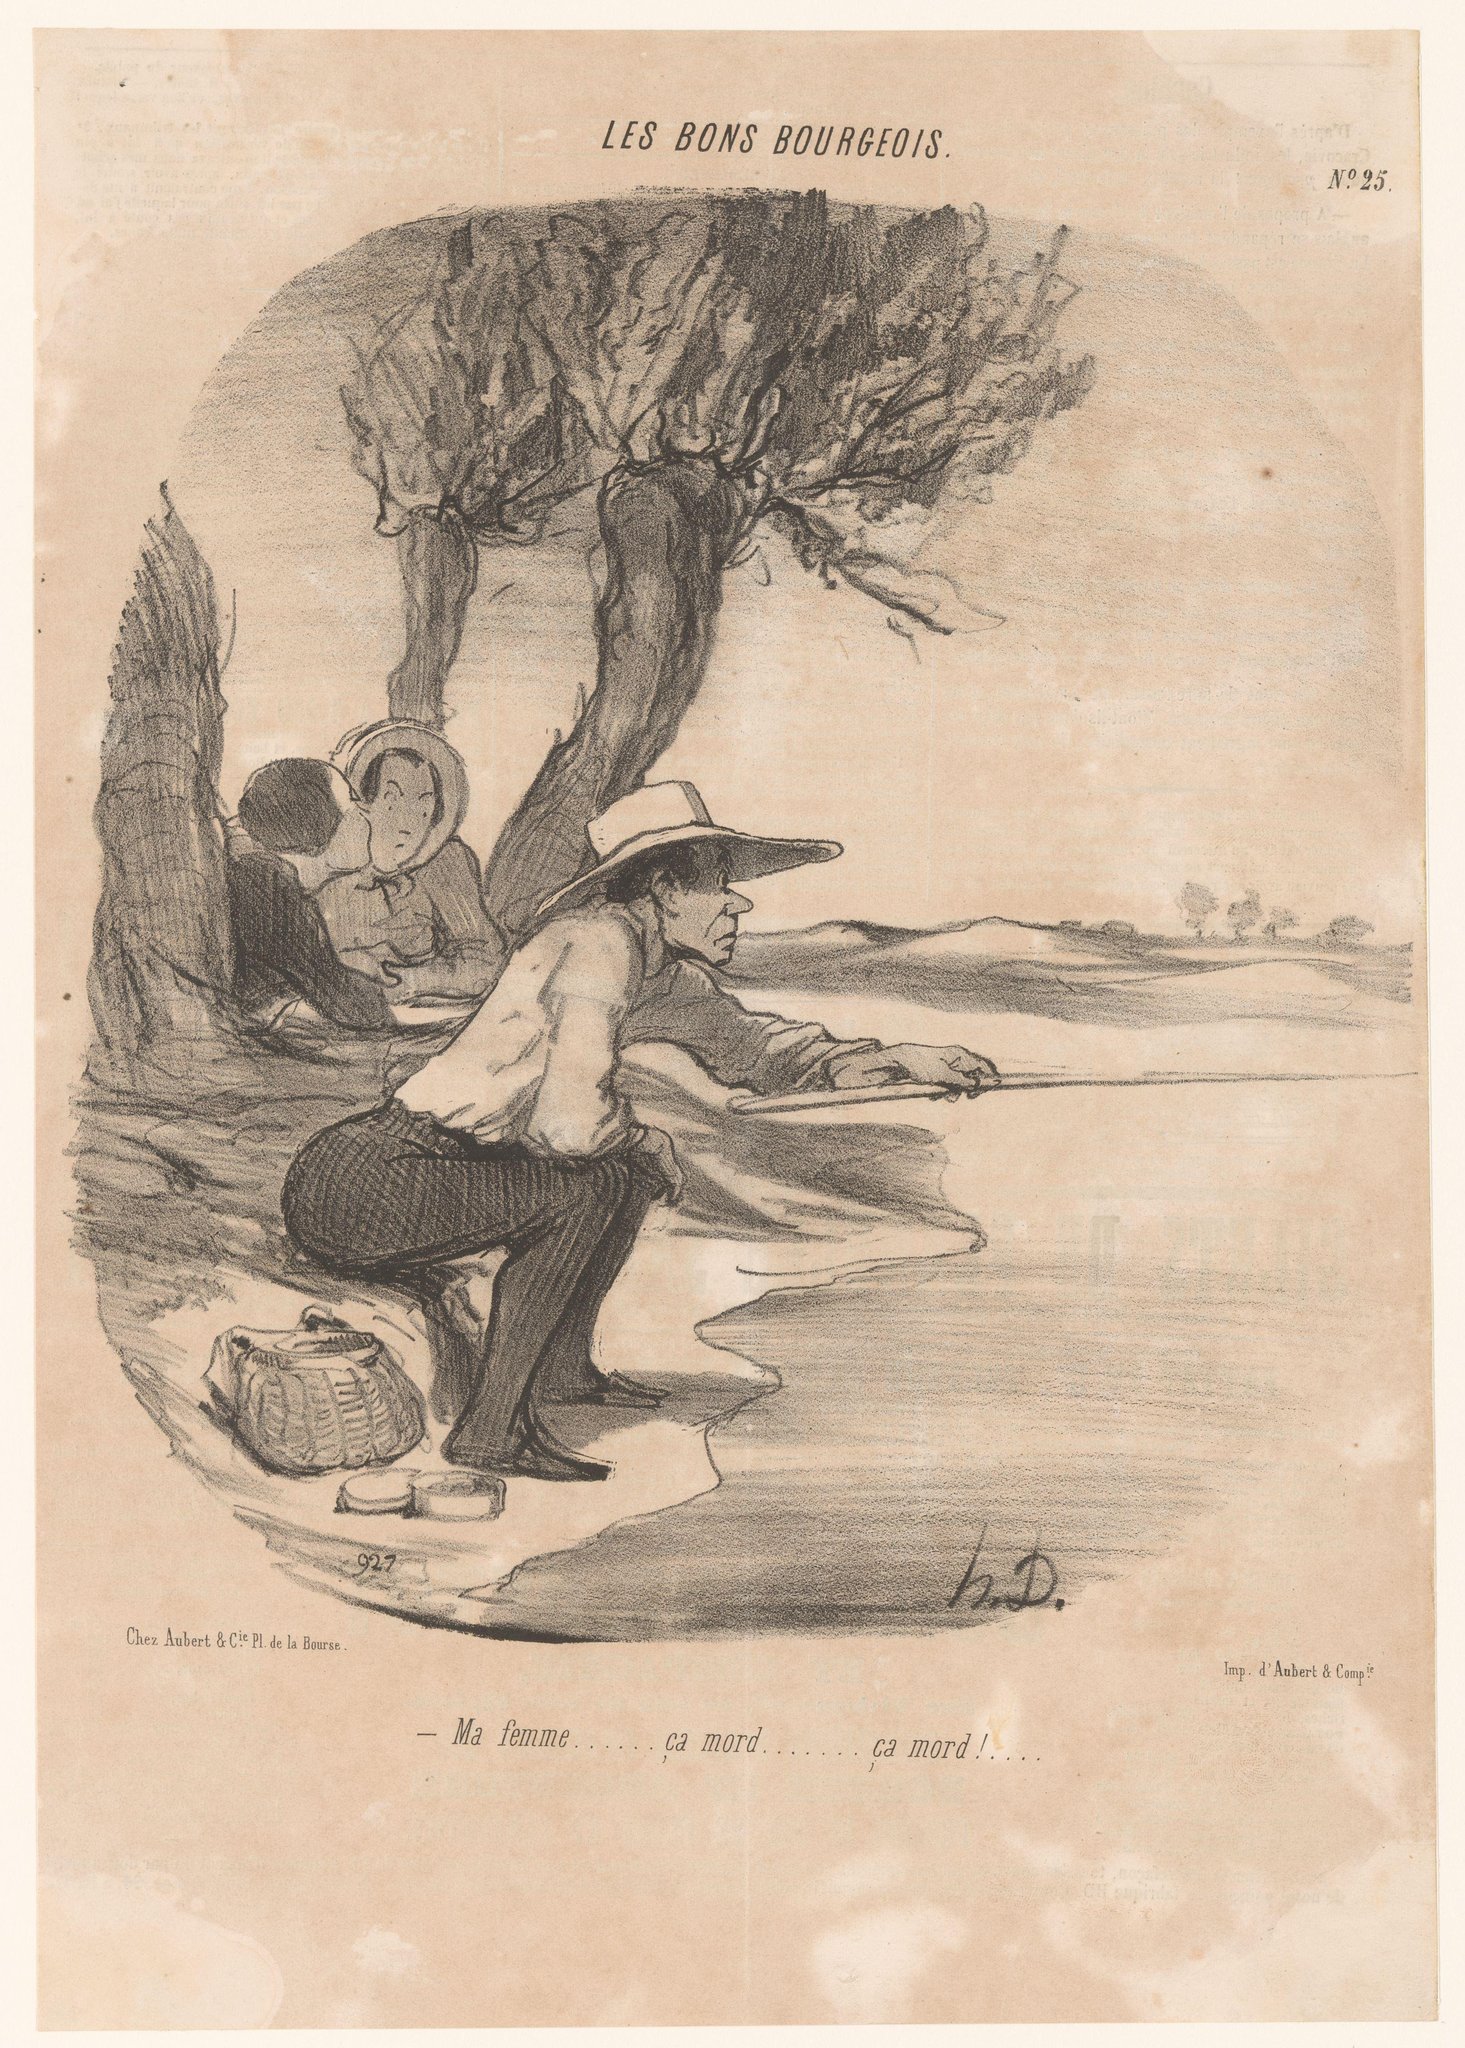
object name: cartoon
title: Goede burgers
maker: honoré daumier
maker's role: draughtsman, painter, print maker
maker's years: 1808-1879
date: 1846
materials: paper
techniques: lithograph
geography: paris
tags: caricatures (human types), fishing (sports)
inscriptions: collector's mark: Lugt 2228a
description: Prent gebruikt voor: Le Charivari, 24-11-1846.